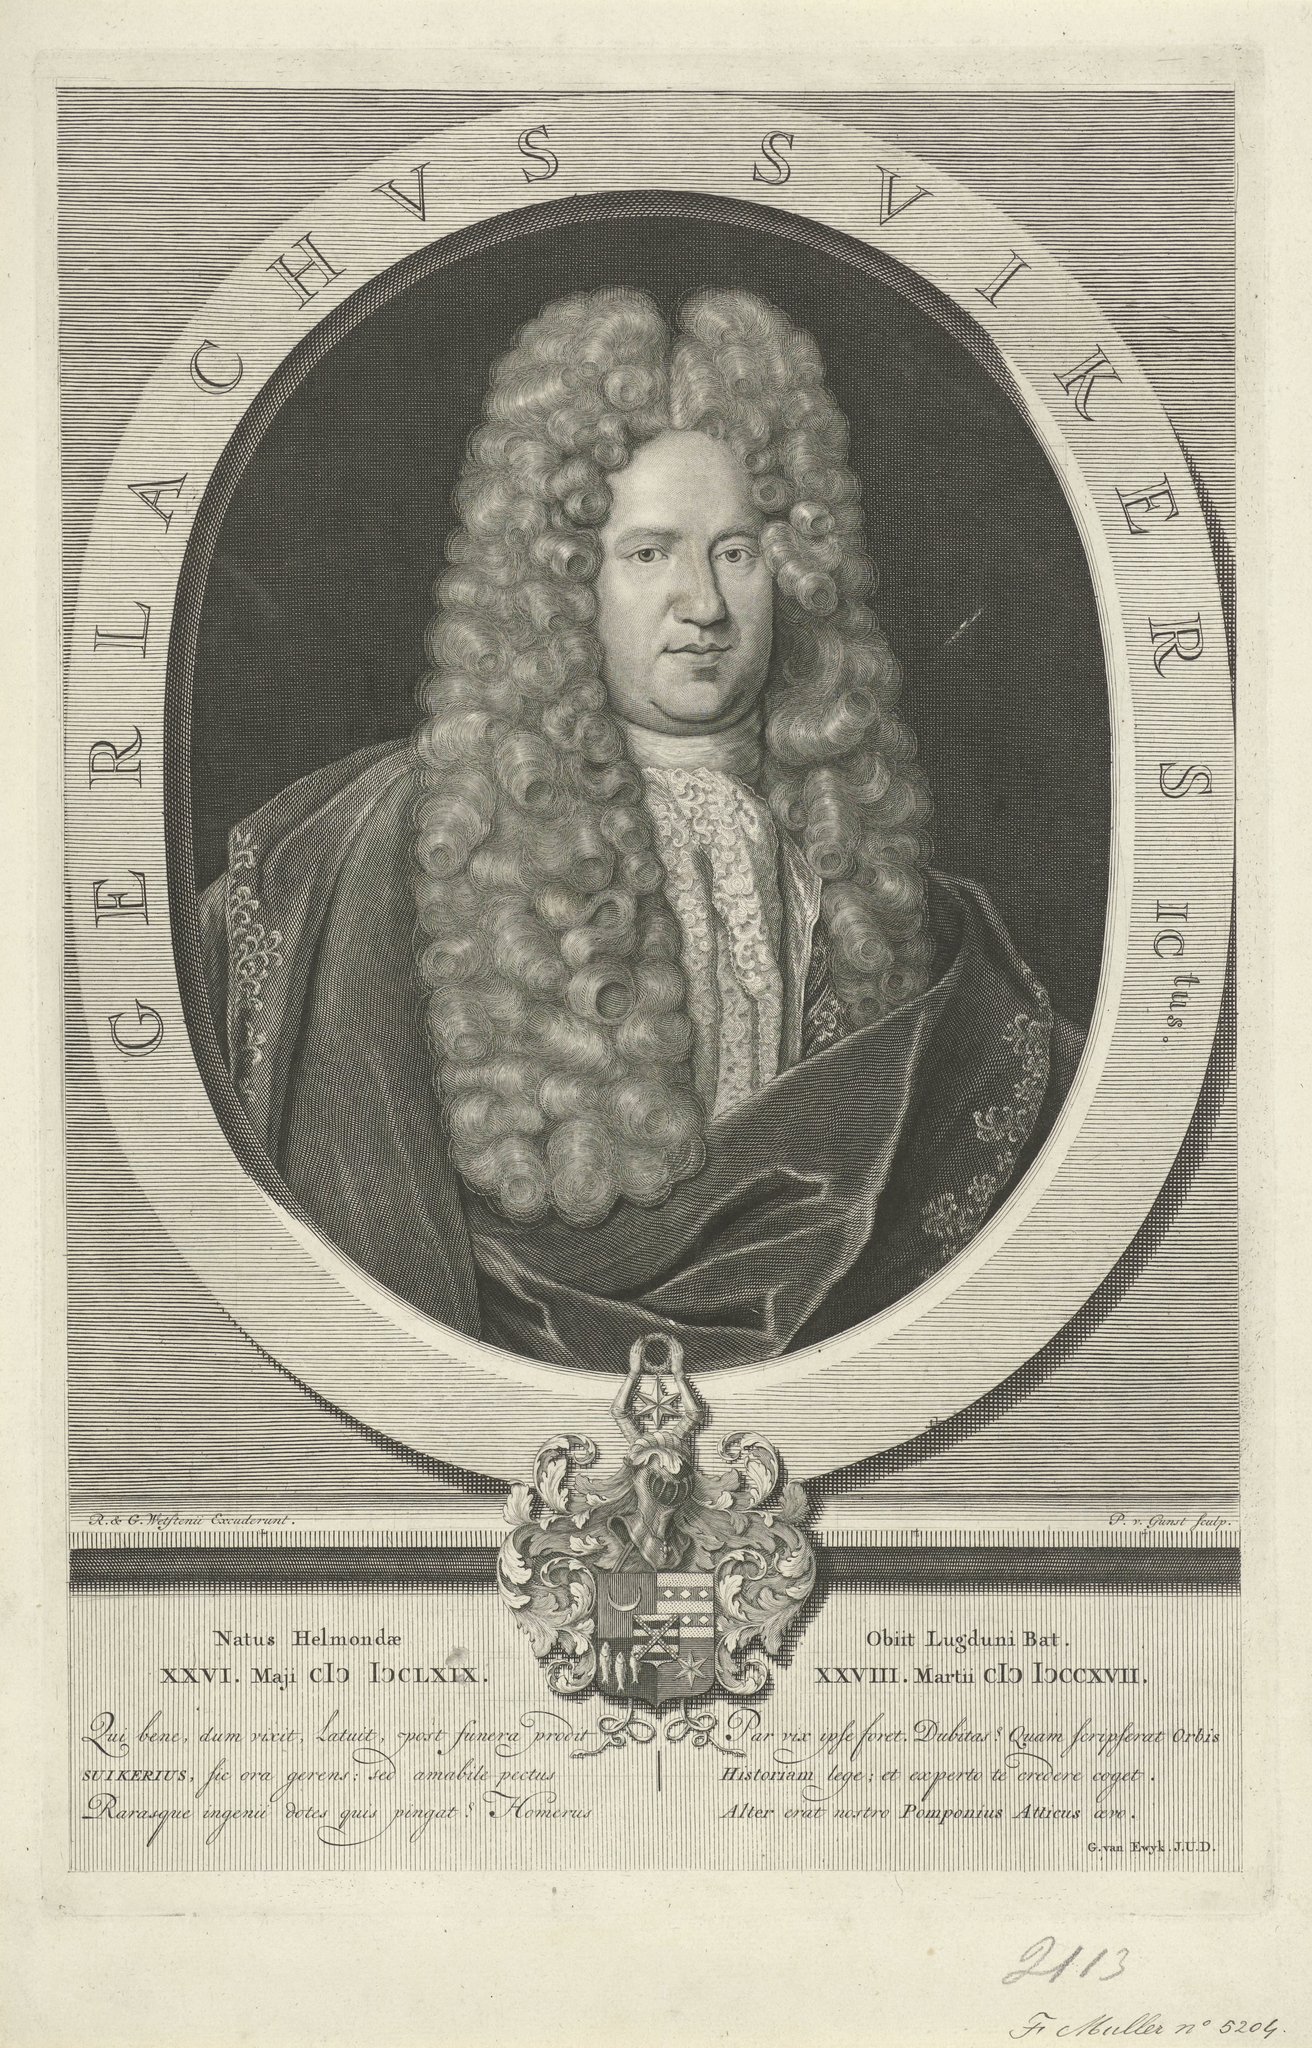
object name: print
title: Portret van Geerlof Suikers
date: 1717-1731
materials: paper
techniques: engraving, etching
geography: amsterdam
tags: leiden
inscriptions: caption: ‘Fr. Muller n. 5204’, collector's mark: Lugt 2228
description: Geerlof Suikers, Nederlands historicus en letterkundige. Onder het portret een wapenschild. De prent heeft een Latijns onderschrift.